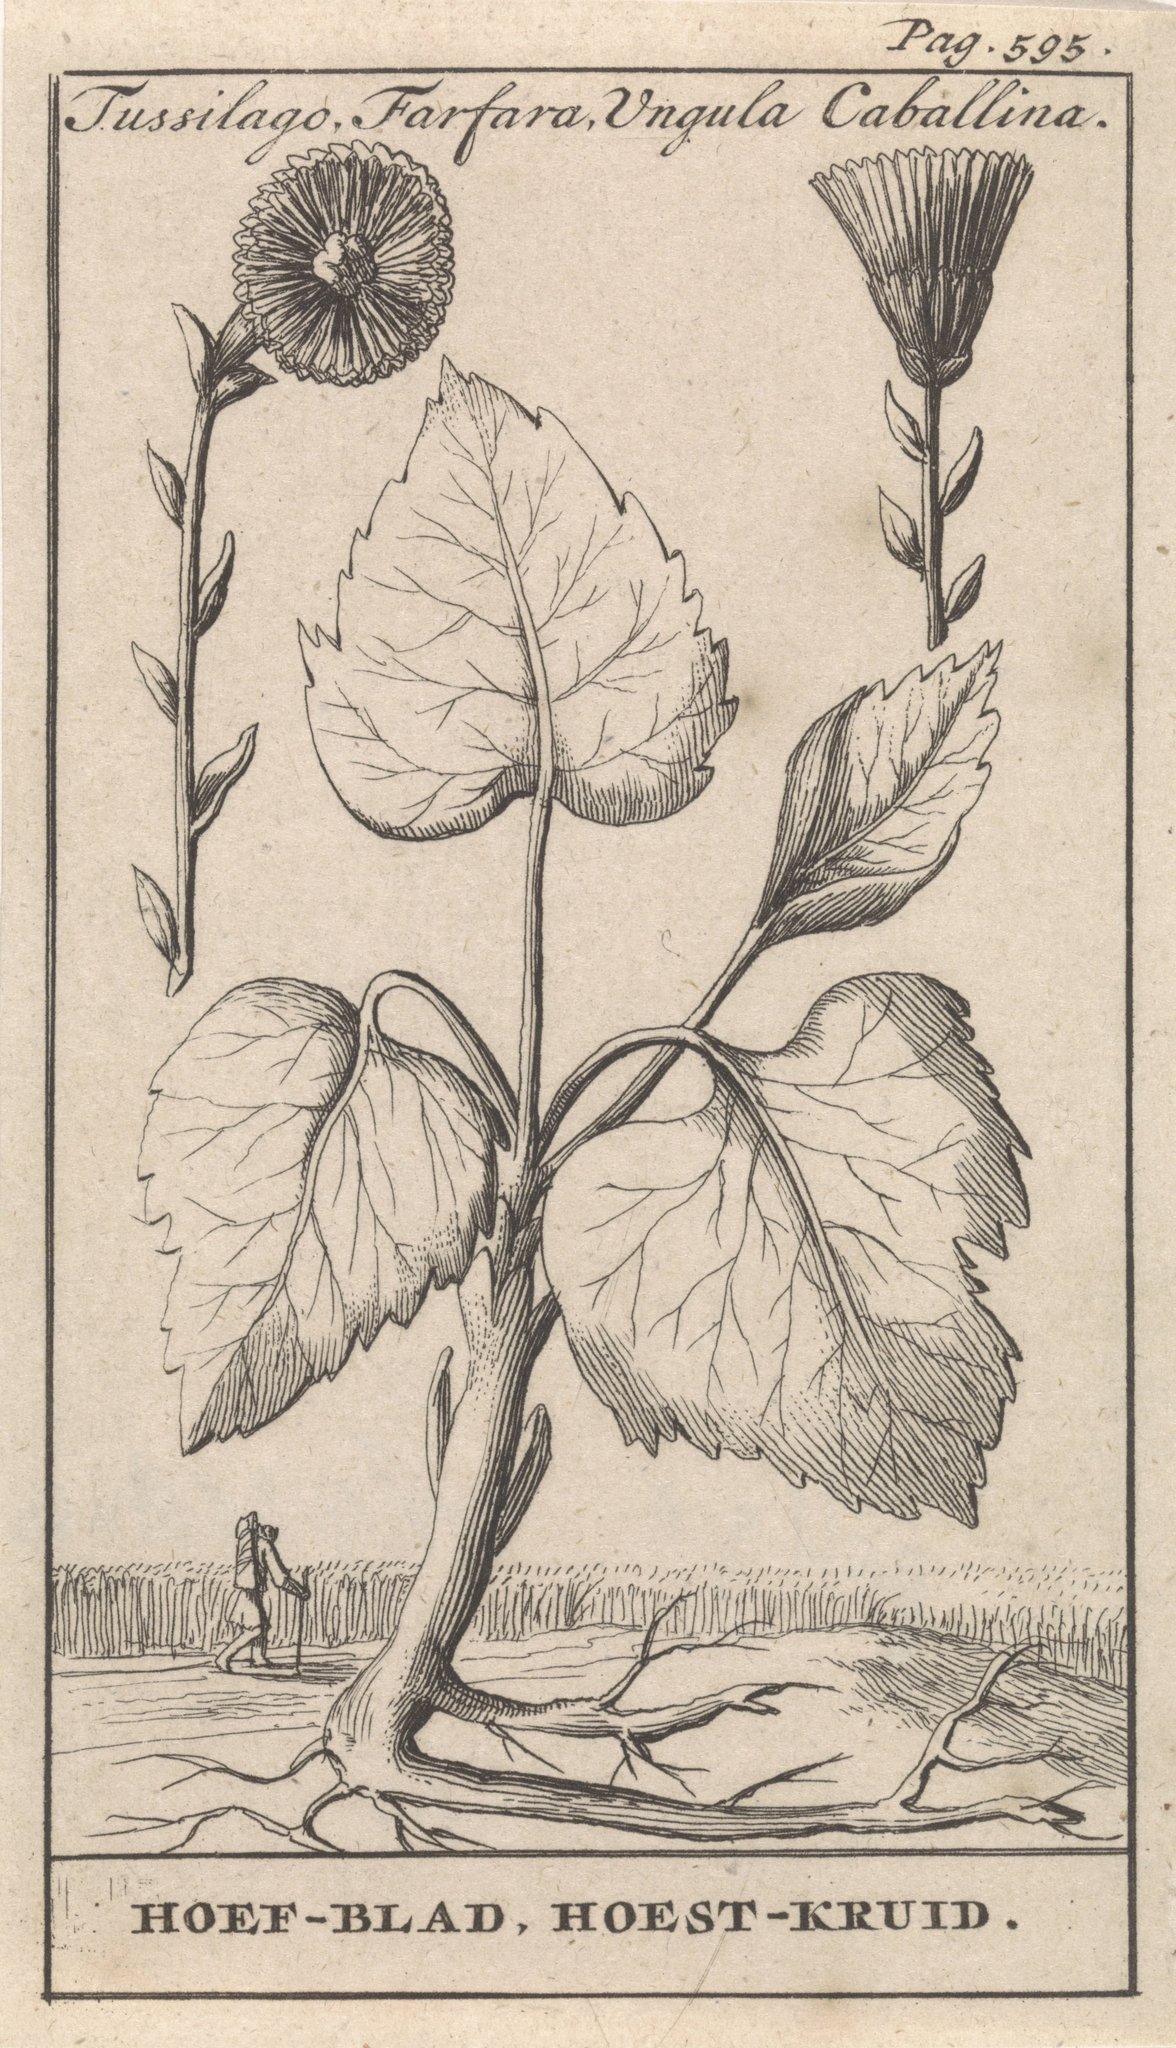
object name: book illustration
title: Klein hoefblad met hoestkruid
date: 1698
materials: paper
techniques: etching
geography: amsterdam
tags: plants and herbs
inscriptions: collector's mark: Lugt 2228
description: Illustratie uit: Blankaart, Steven. Den Neder-landschen herbarius ofte Kruid-boek der voornaamste kruiden. Amsterdam: Jan Claesz ten Hoorn, 1698.